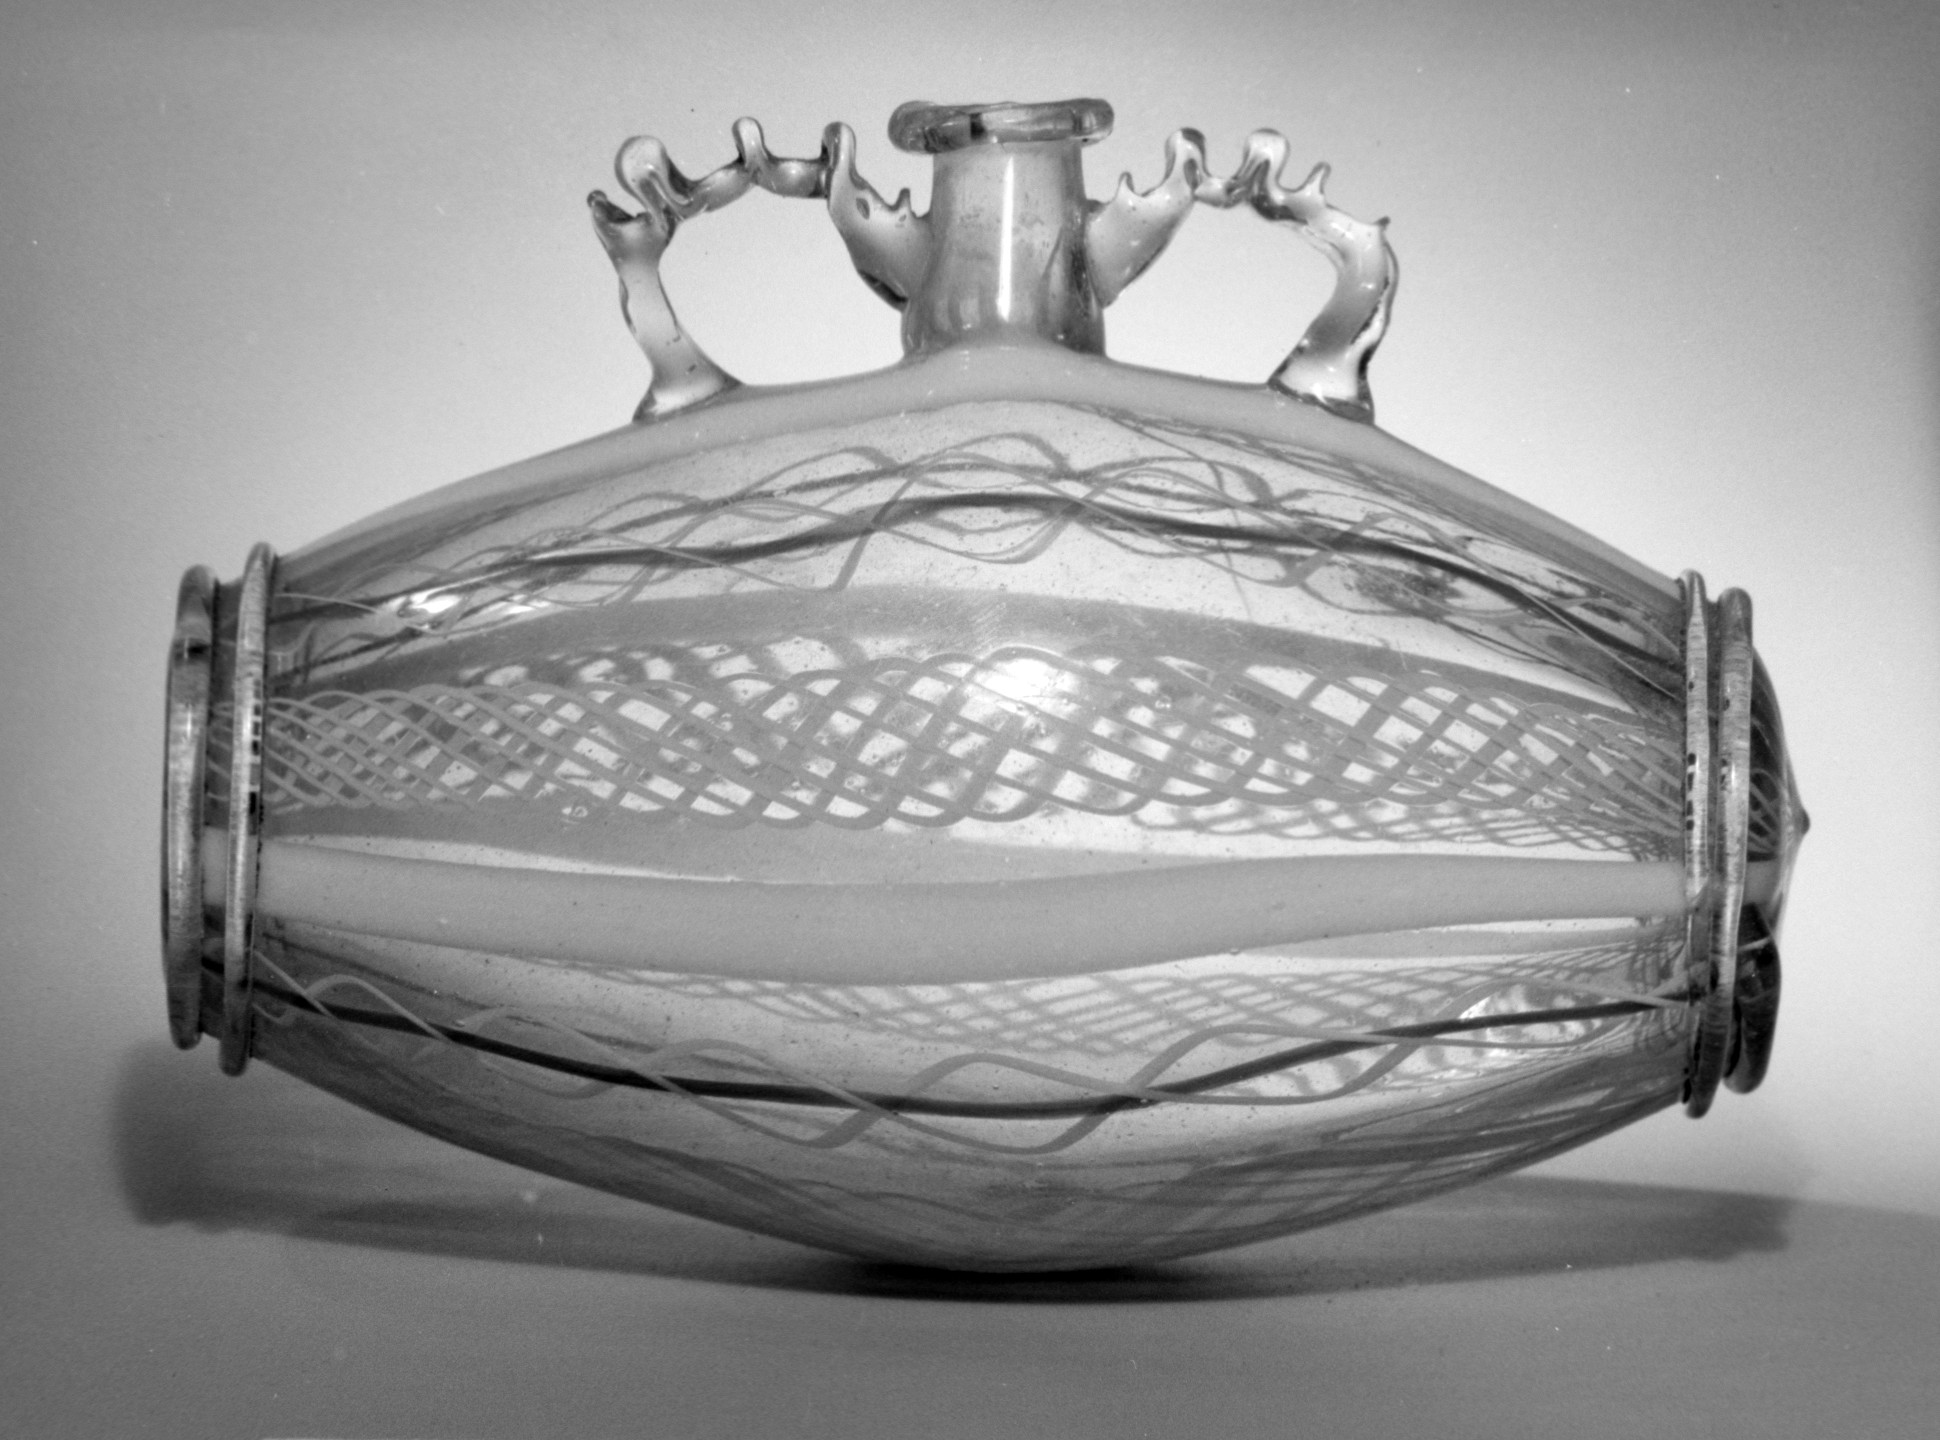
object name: flask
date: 1601-1800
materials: glass